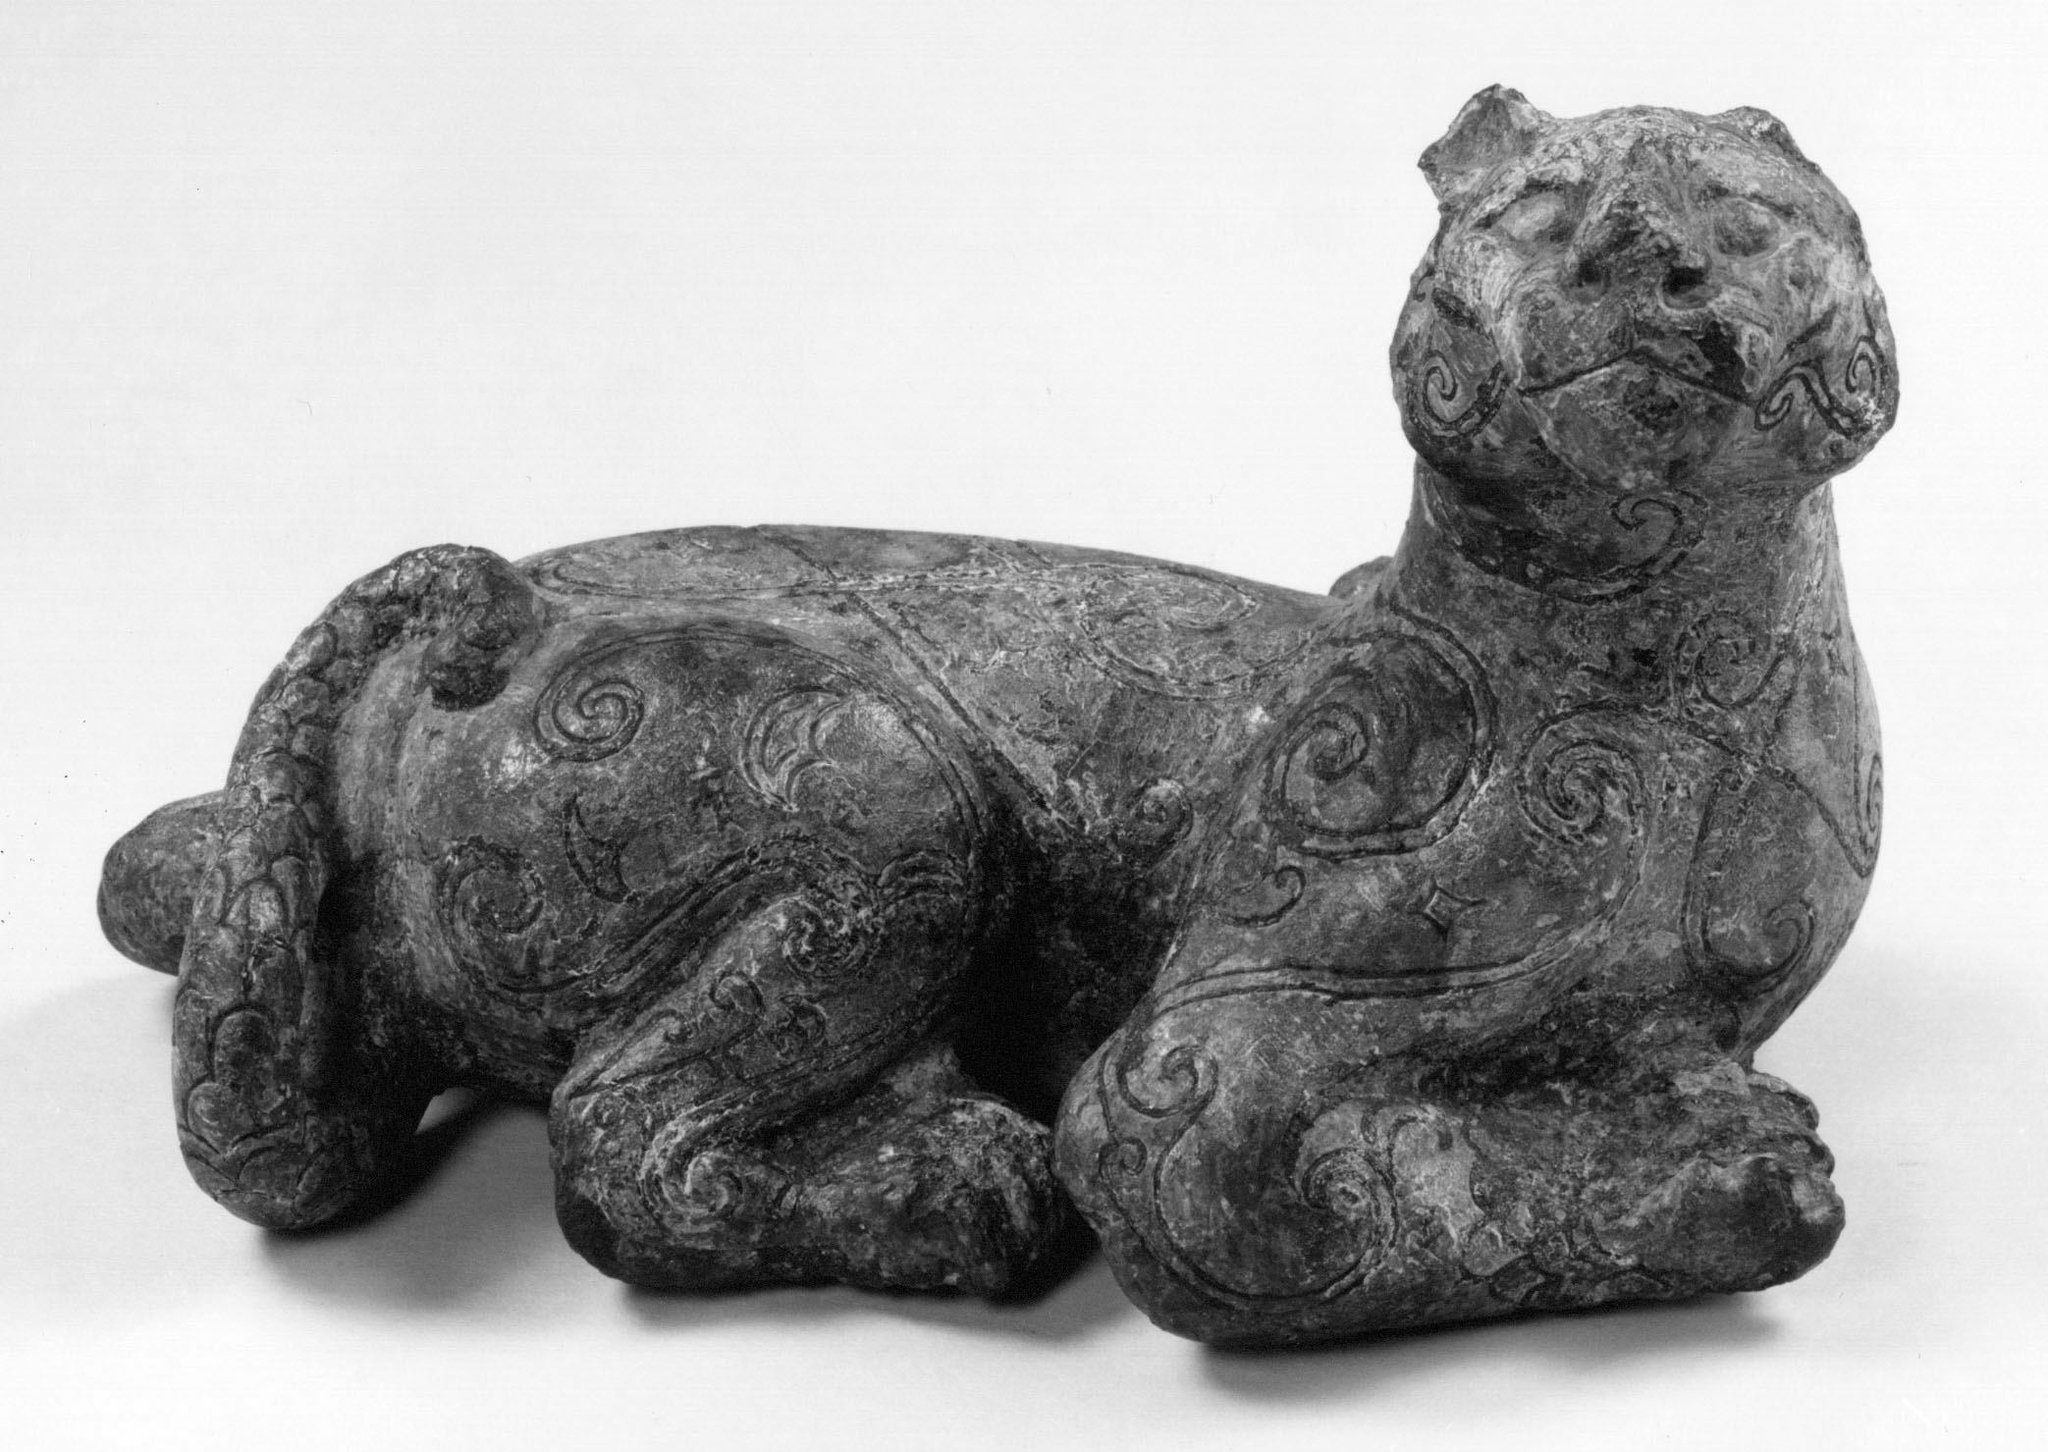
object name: ornament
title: Reclining tiger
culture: chinese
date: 400-201 BCE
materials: bronze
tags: tigers